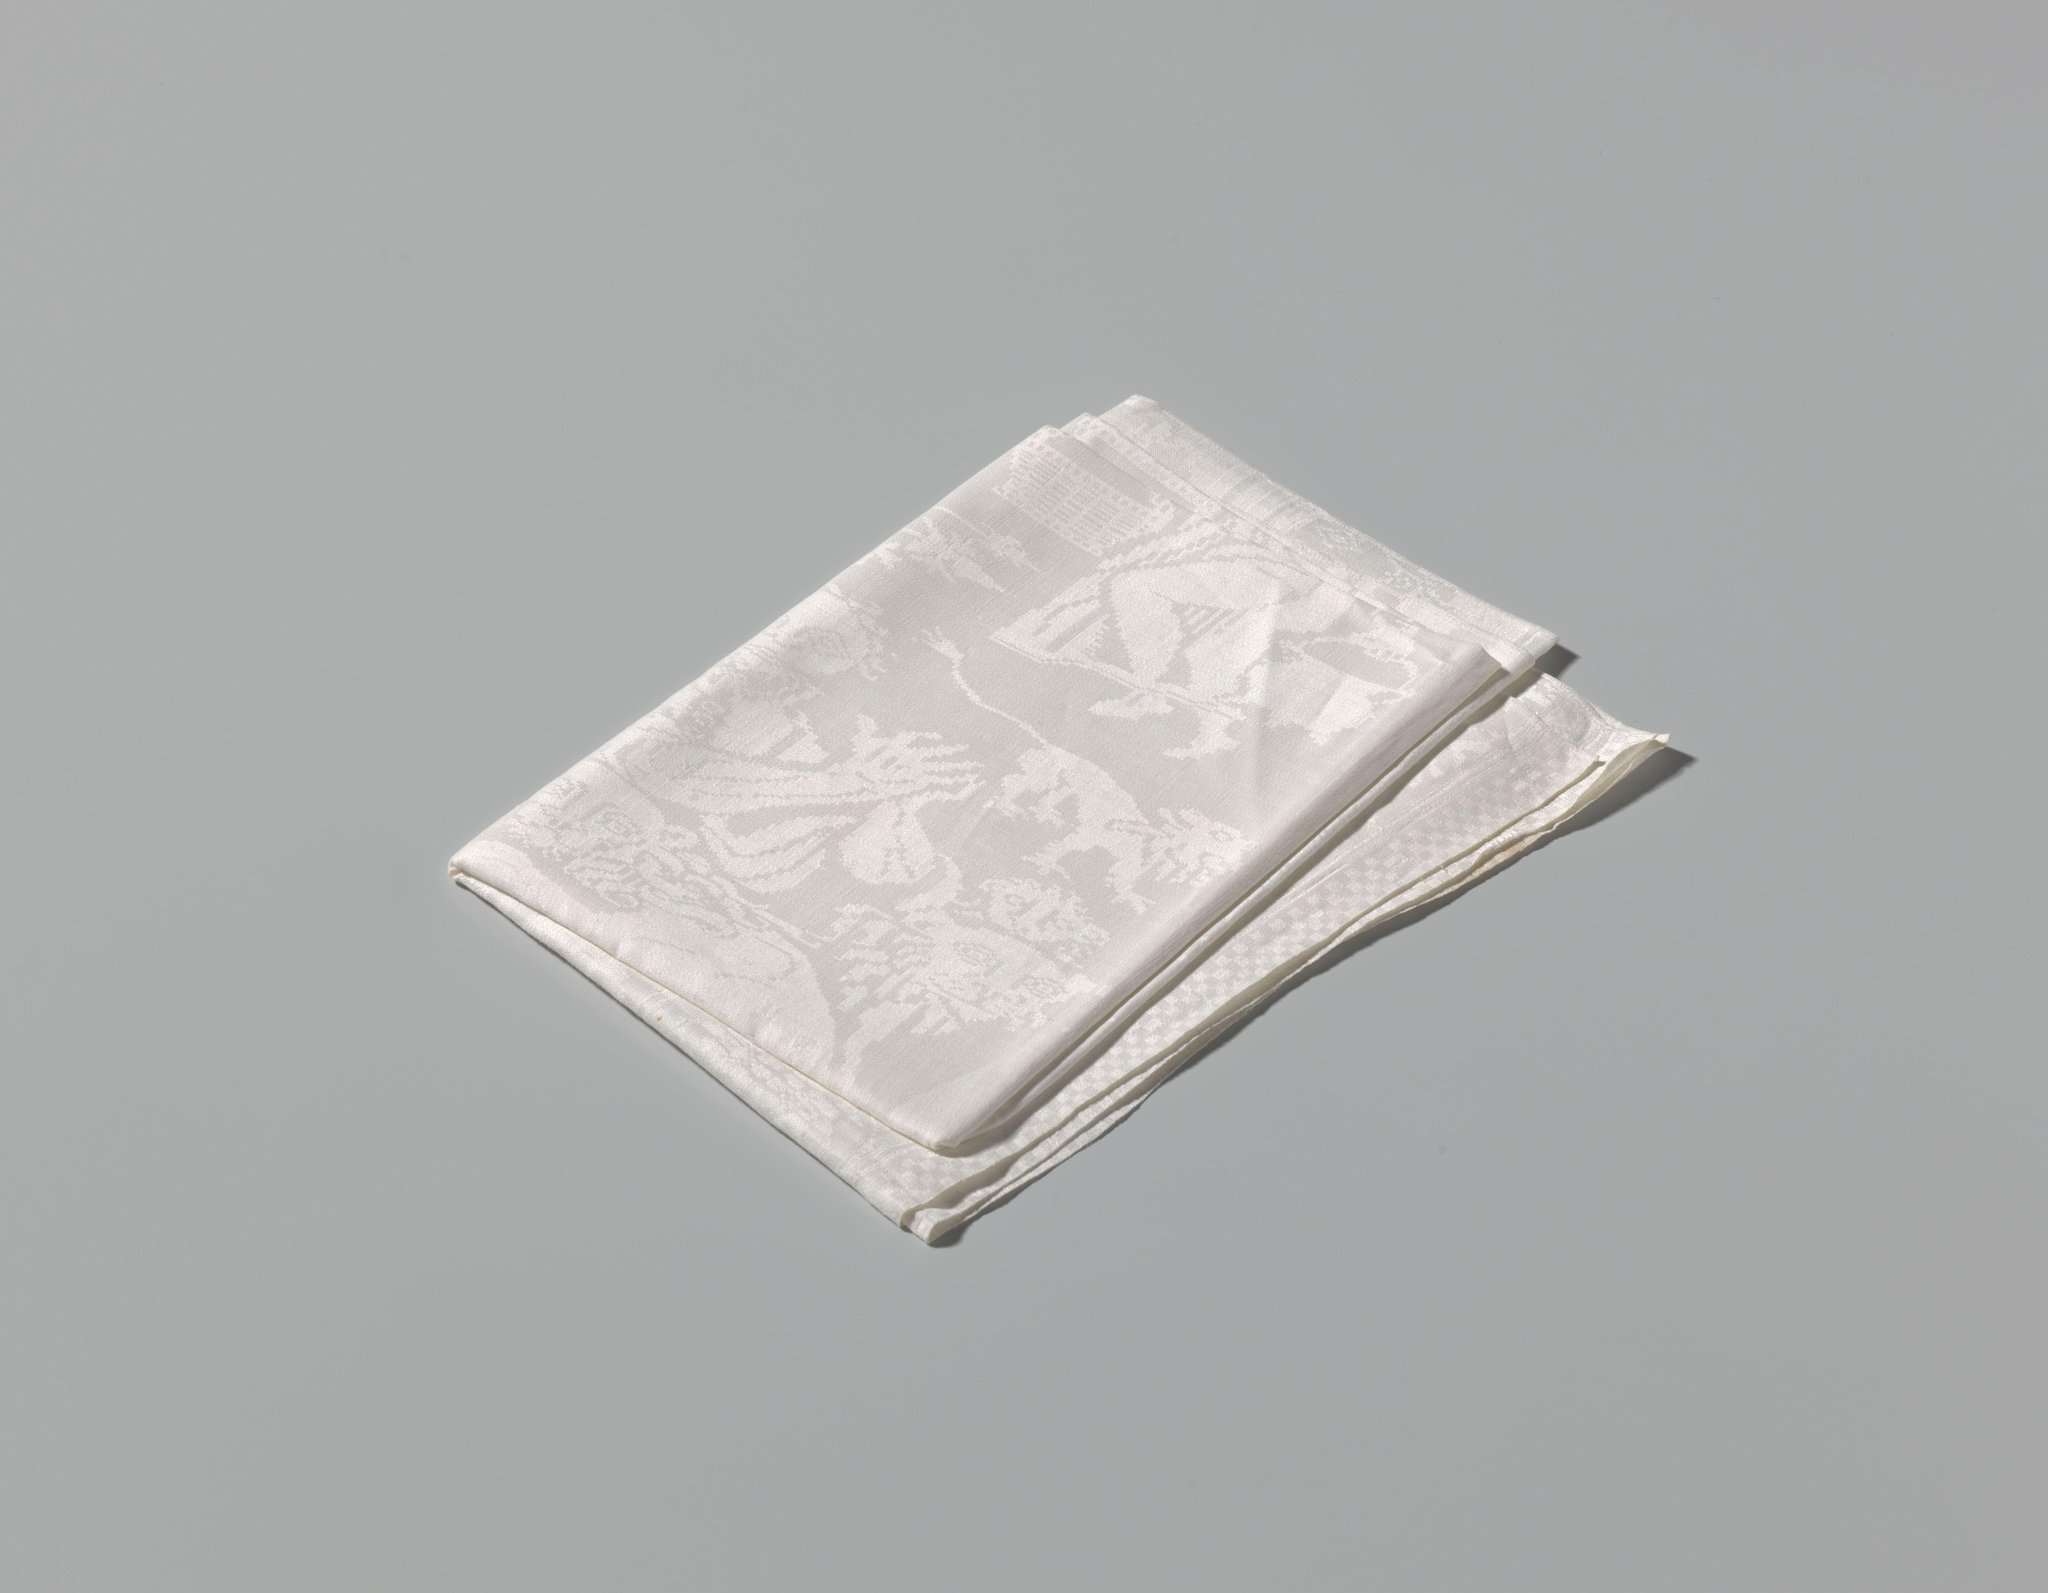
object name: napkin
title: Servet met de geschiedenis van Daniël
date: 1600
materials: linen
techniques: damask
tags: the story of the prophet daniel; his visions and prophecies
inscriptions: mark: ‘TO 12’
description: Servet van linnendamast met de geschiedenis van Daniël. Middenveld: het symmetrisch verdubbelde patroon vertoont van onder naar boven drie taferelen: 1 Op de middenas een beeld. Bijschrift: DEN AFGOD BEL. 2 Daniël in de leeuwenkuil. Habakuk met mand en ijzeren pot wordt aan de haren geleid door een engel. Daaronder zit Daniël met smekend handgebaar. In zijn schoot heeft een leeuw zijn kop gevlijd. Andere leeuwen rondom, evenals een doodshoofd en bot. Onderschrift: O HEER WILT MI BISTAEN. 3 Daniël doodt de draak. Aan de buitenzijde de draak met pijlvormige tong, in wiens geopende muil een hand van Daniël de pekkoeken werpt. Gedoornde vliesvleugelen, een gespleten kronkelende staart kenmerken het opzittende monster. Daniël met een zestiende-eeuwse golillakraag. De vorst Cyrus half afgesneden. Onderaan binnen twee lijven: OM DE DOOT TE ONTGAEN. Staande randen: spitsovale ranken met vogels.